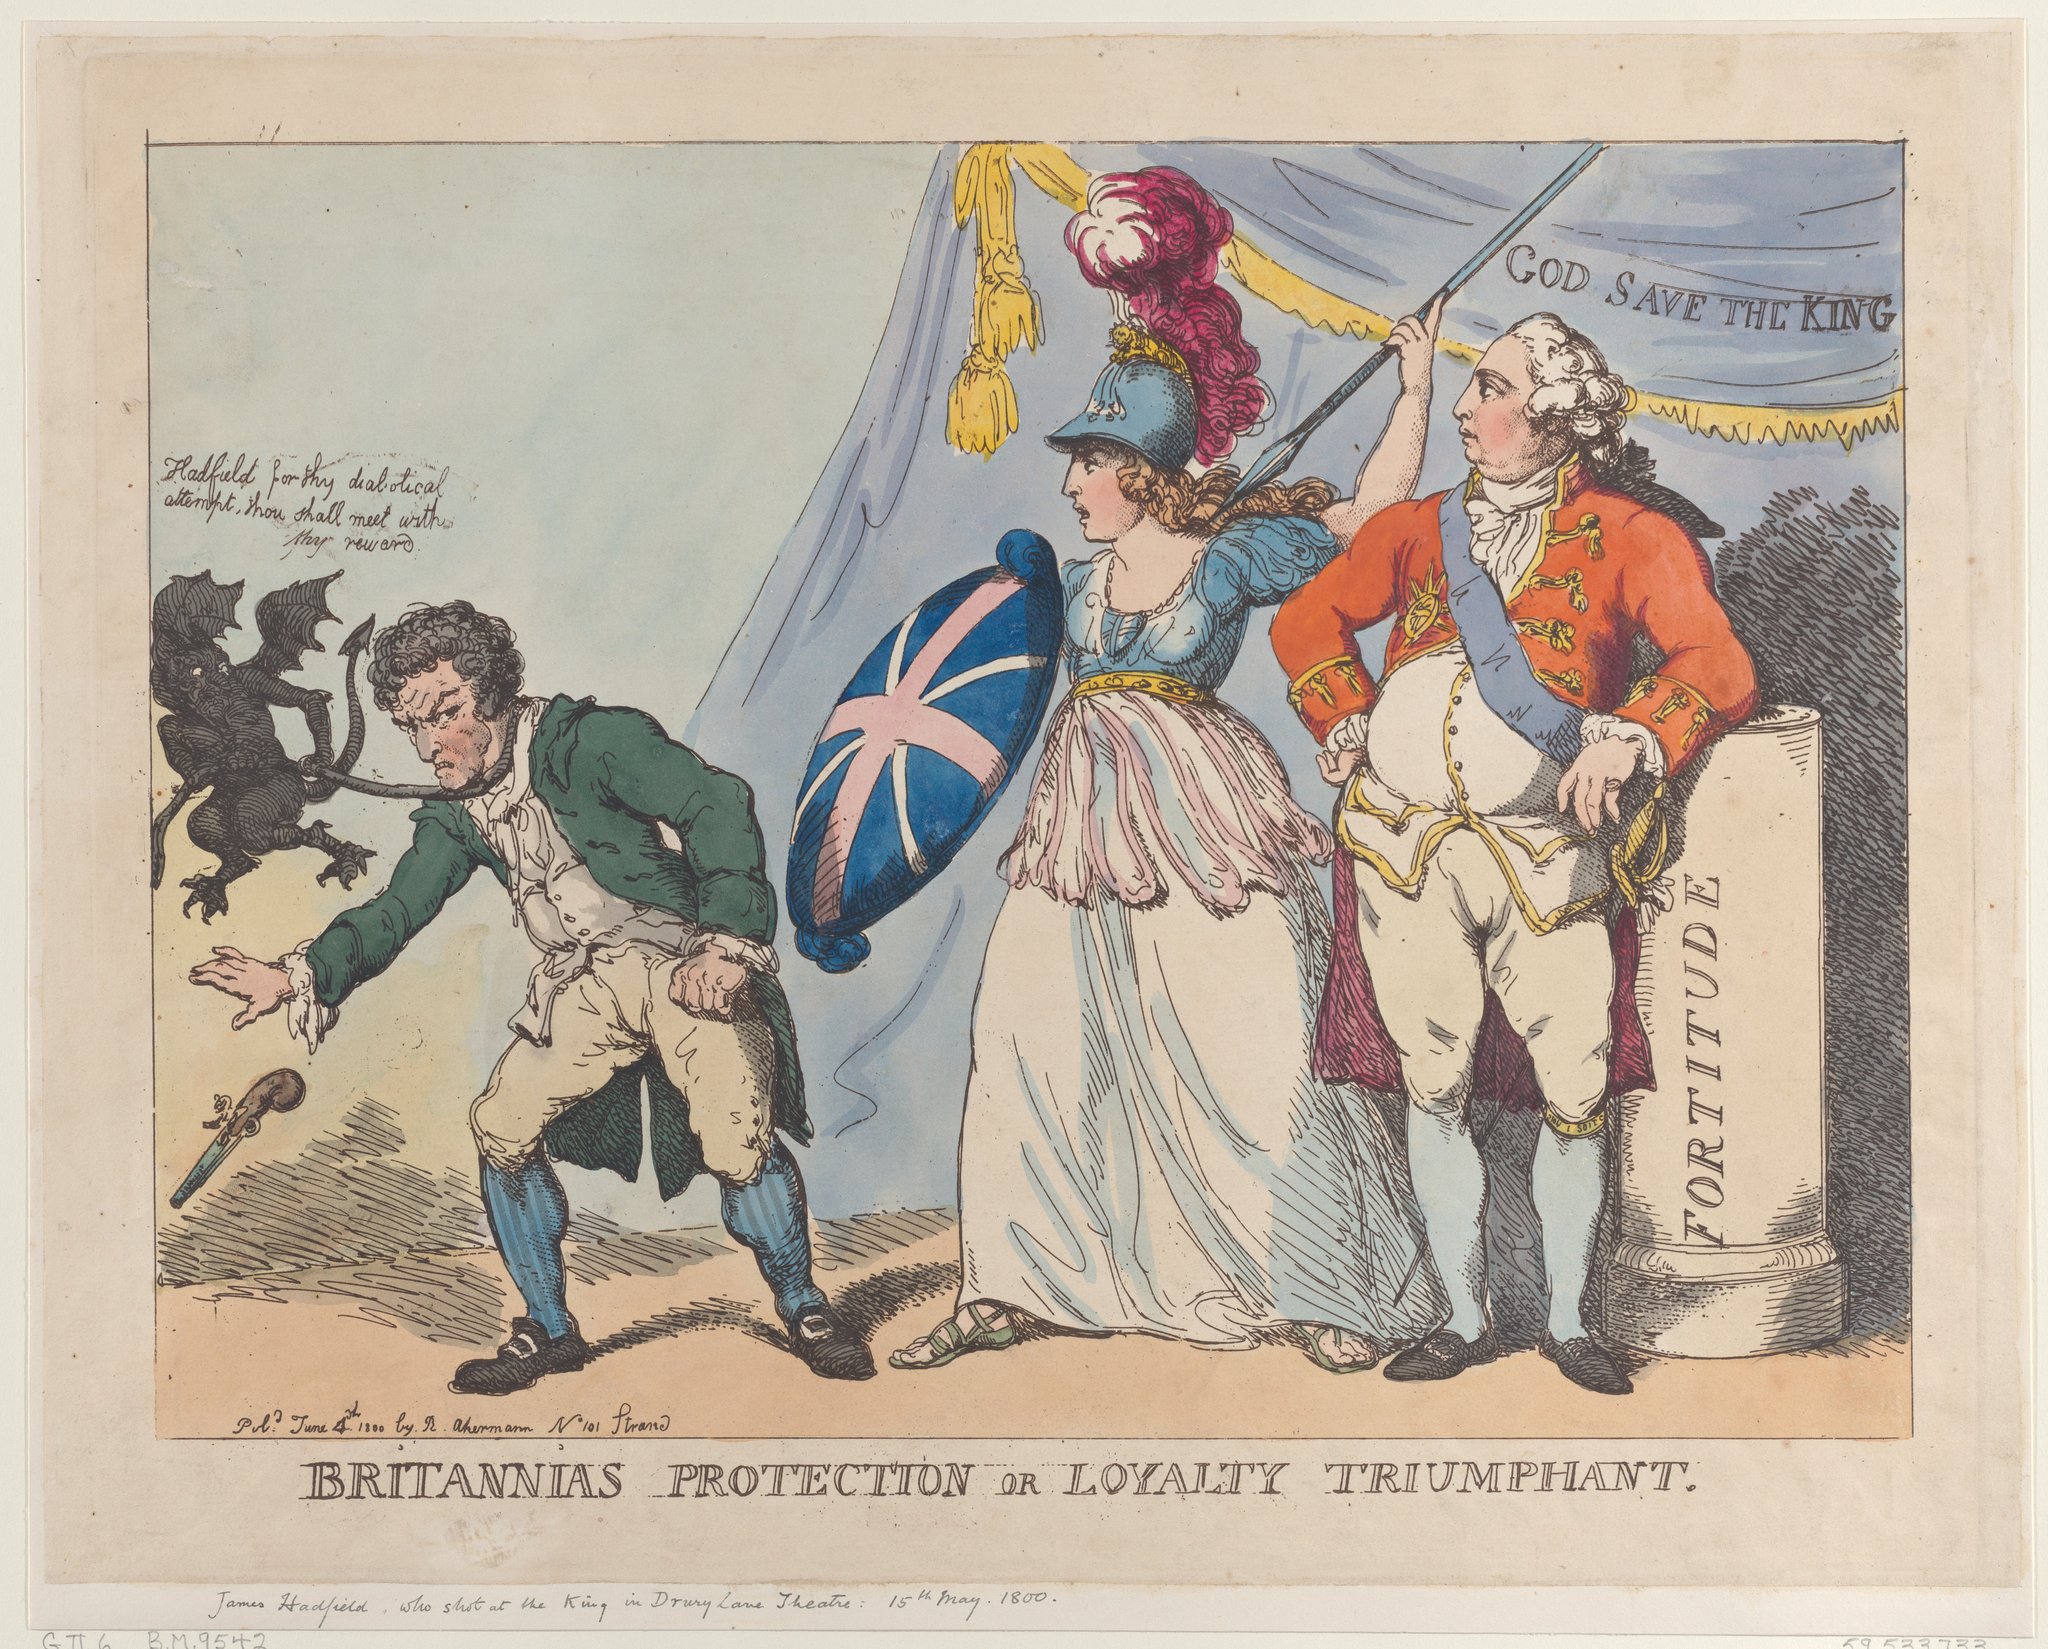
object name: print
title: Britannia's Protection or Loyalty Triumphant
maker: thomas rowlandson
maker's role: artist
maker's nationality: british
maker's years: 1757-1827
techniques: etching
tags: satire,kings,men,women